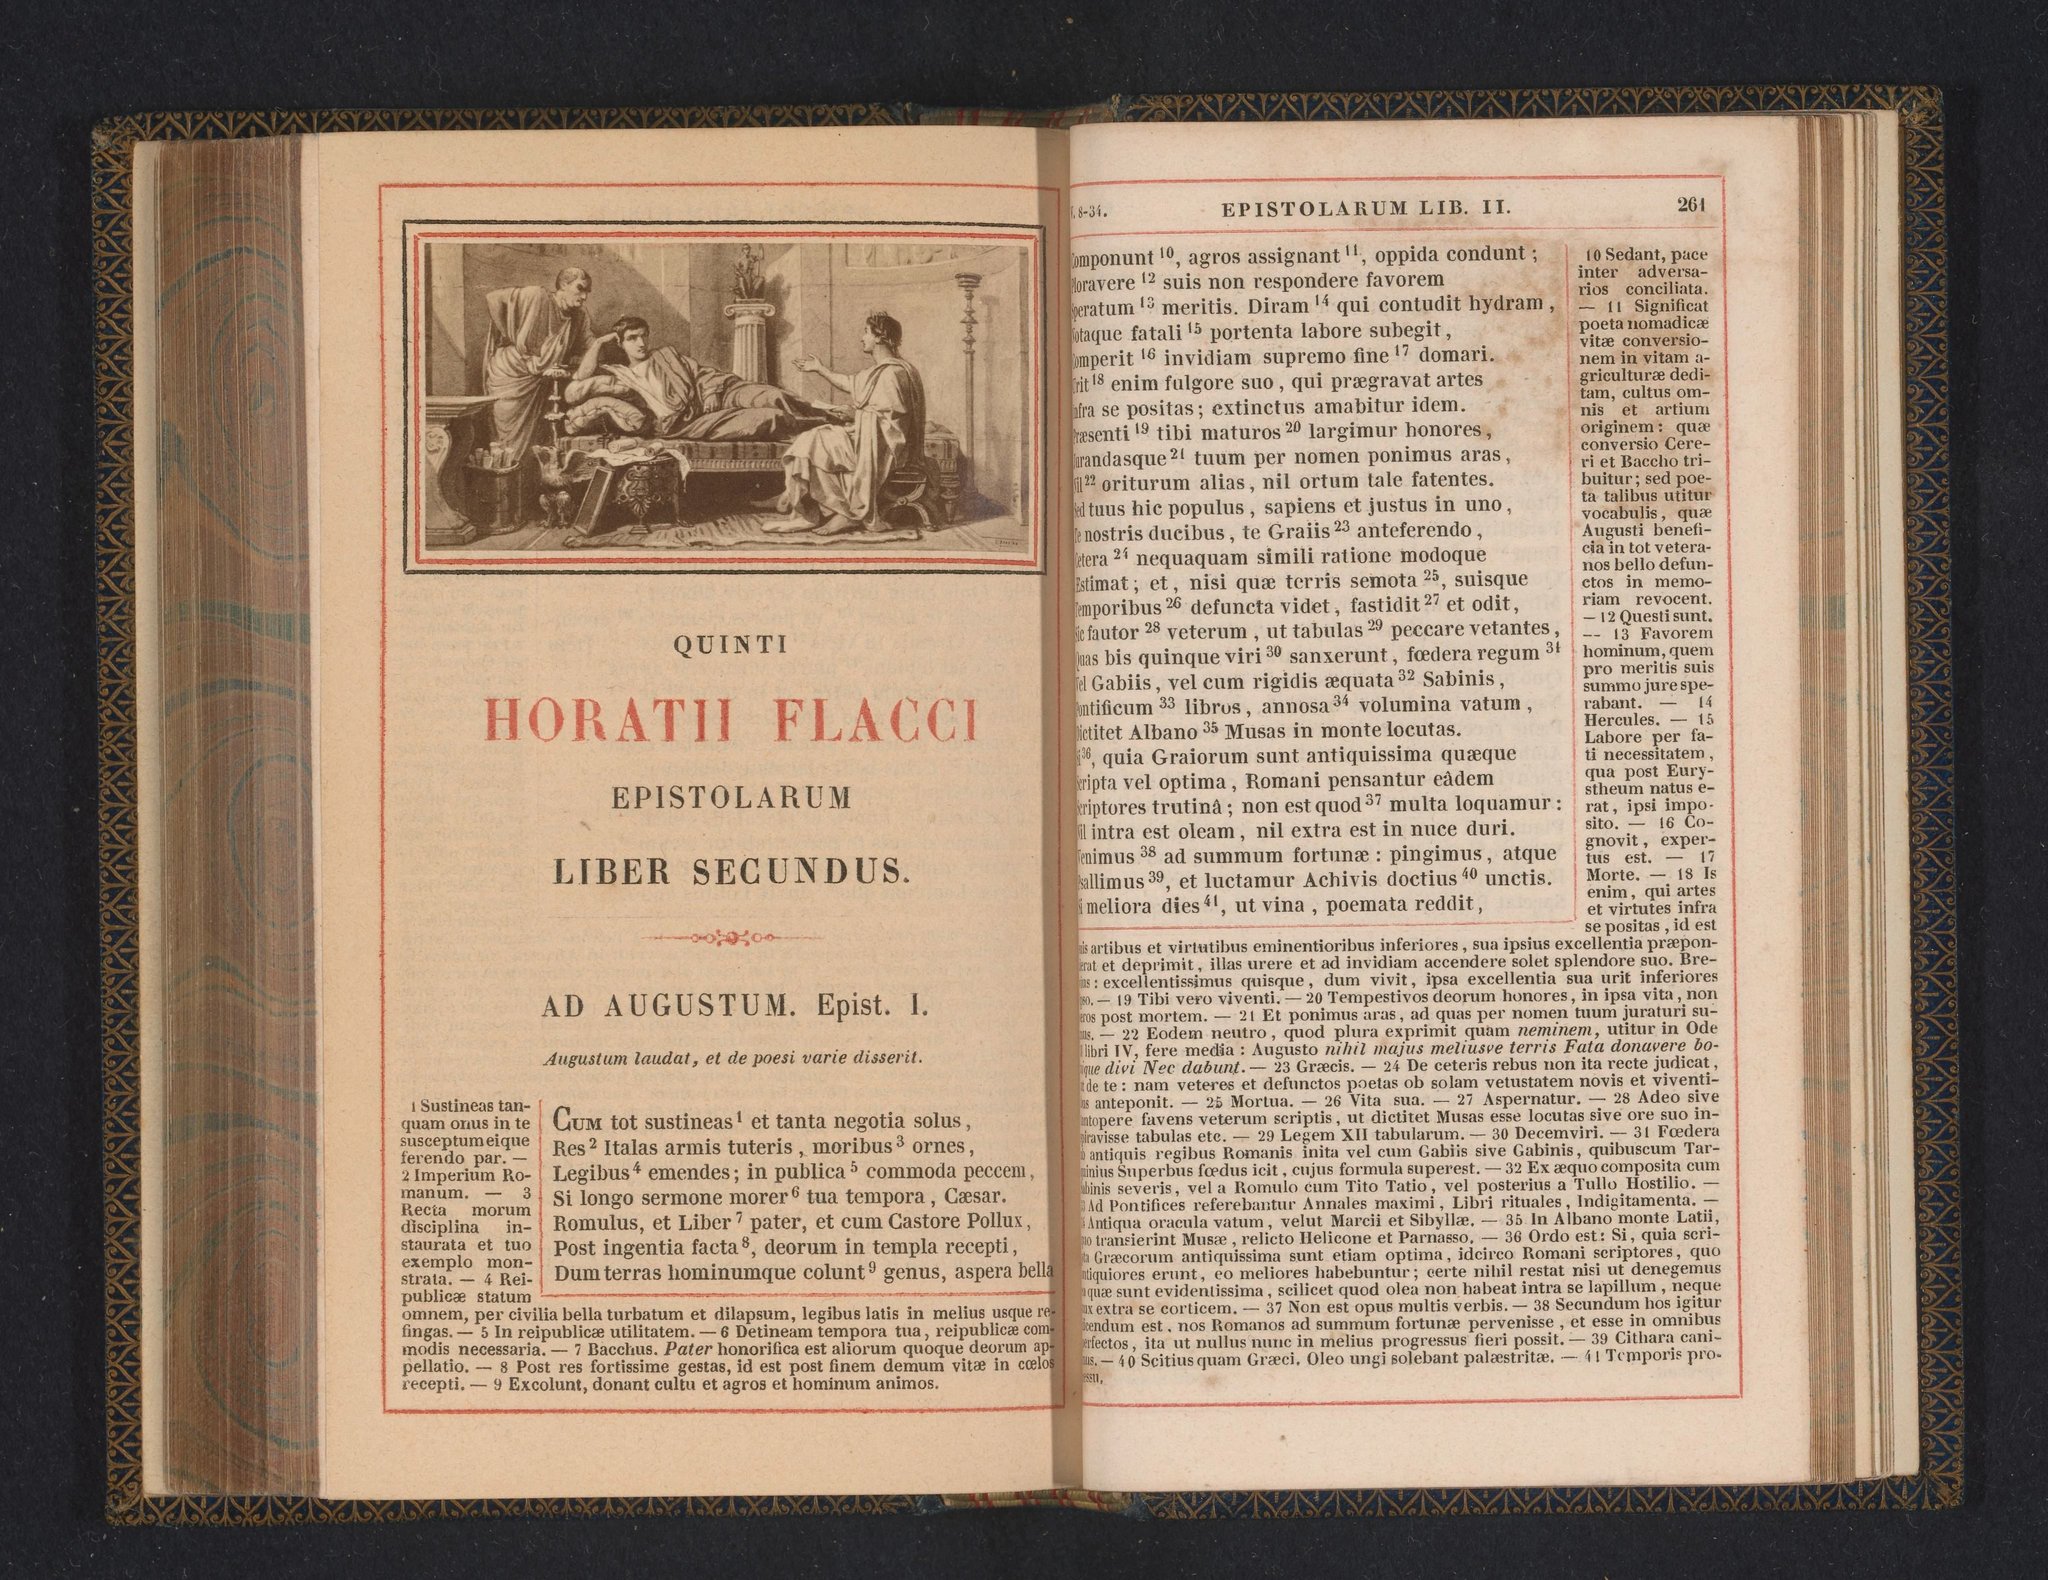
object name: page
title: Fotoreproductie van een schilderij, voorstellende een man op een aanligbed en twee staande mannen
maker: Anonymous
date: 1850-1855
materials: photographic support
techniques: albumen print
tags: interior ~ representation of a building, lying figure, couch, sofa, settee